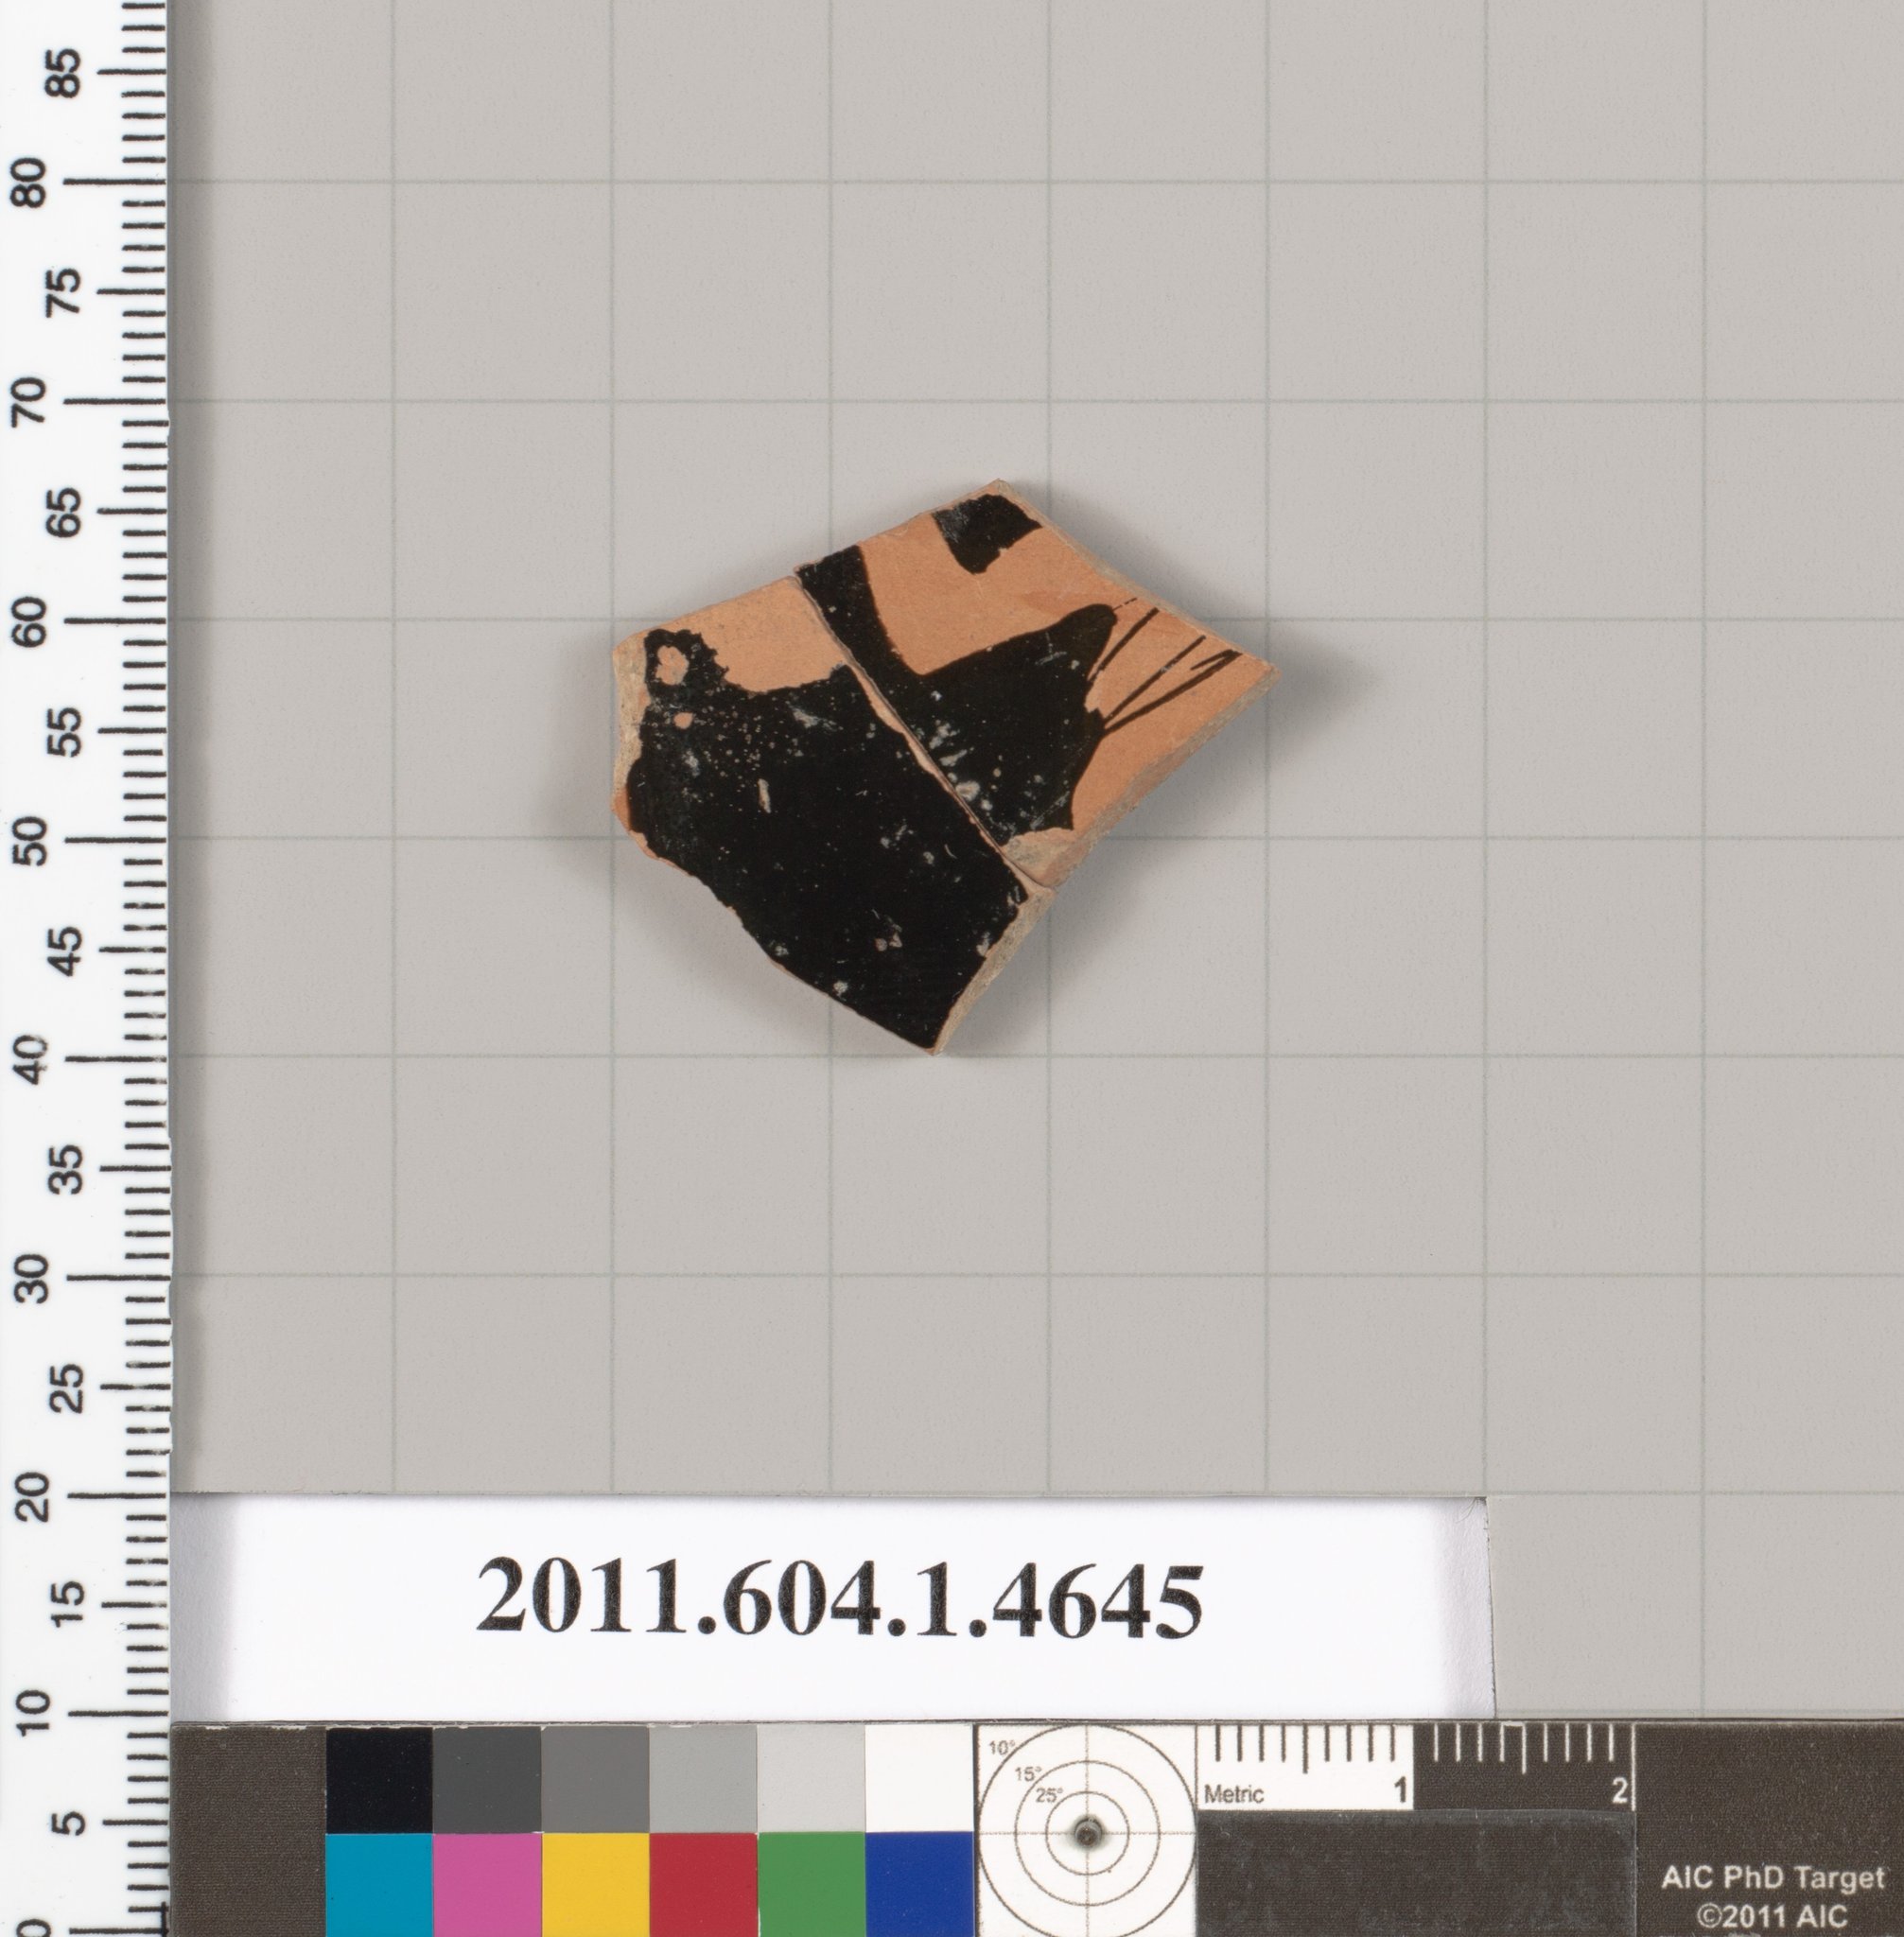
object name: kylix fragment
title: Terracotta fragment of a kylix (drinking cup)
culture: greek, attic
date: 475-451 BCE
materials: terracotta